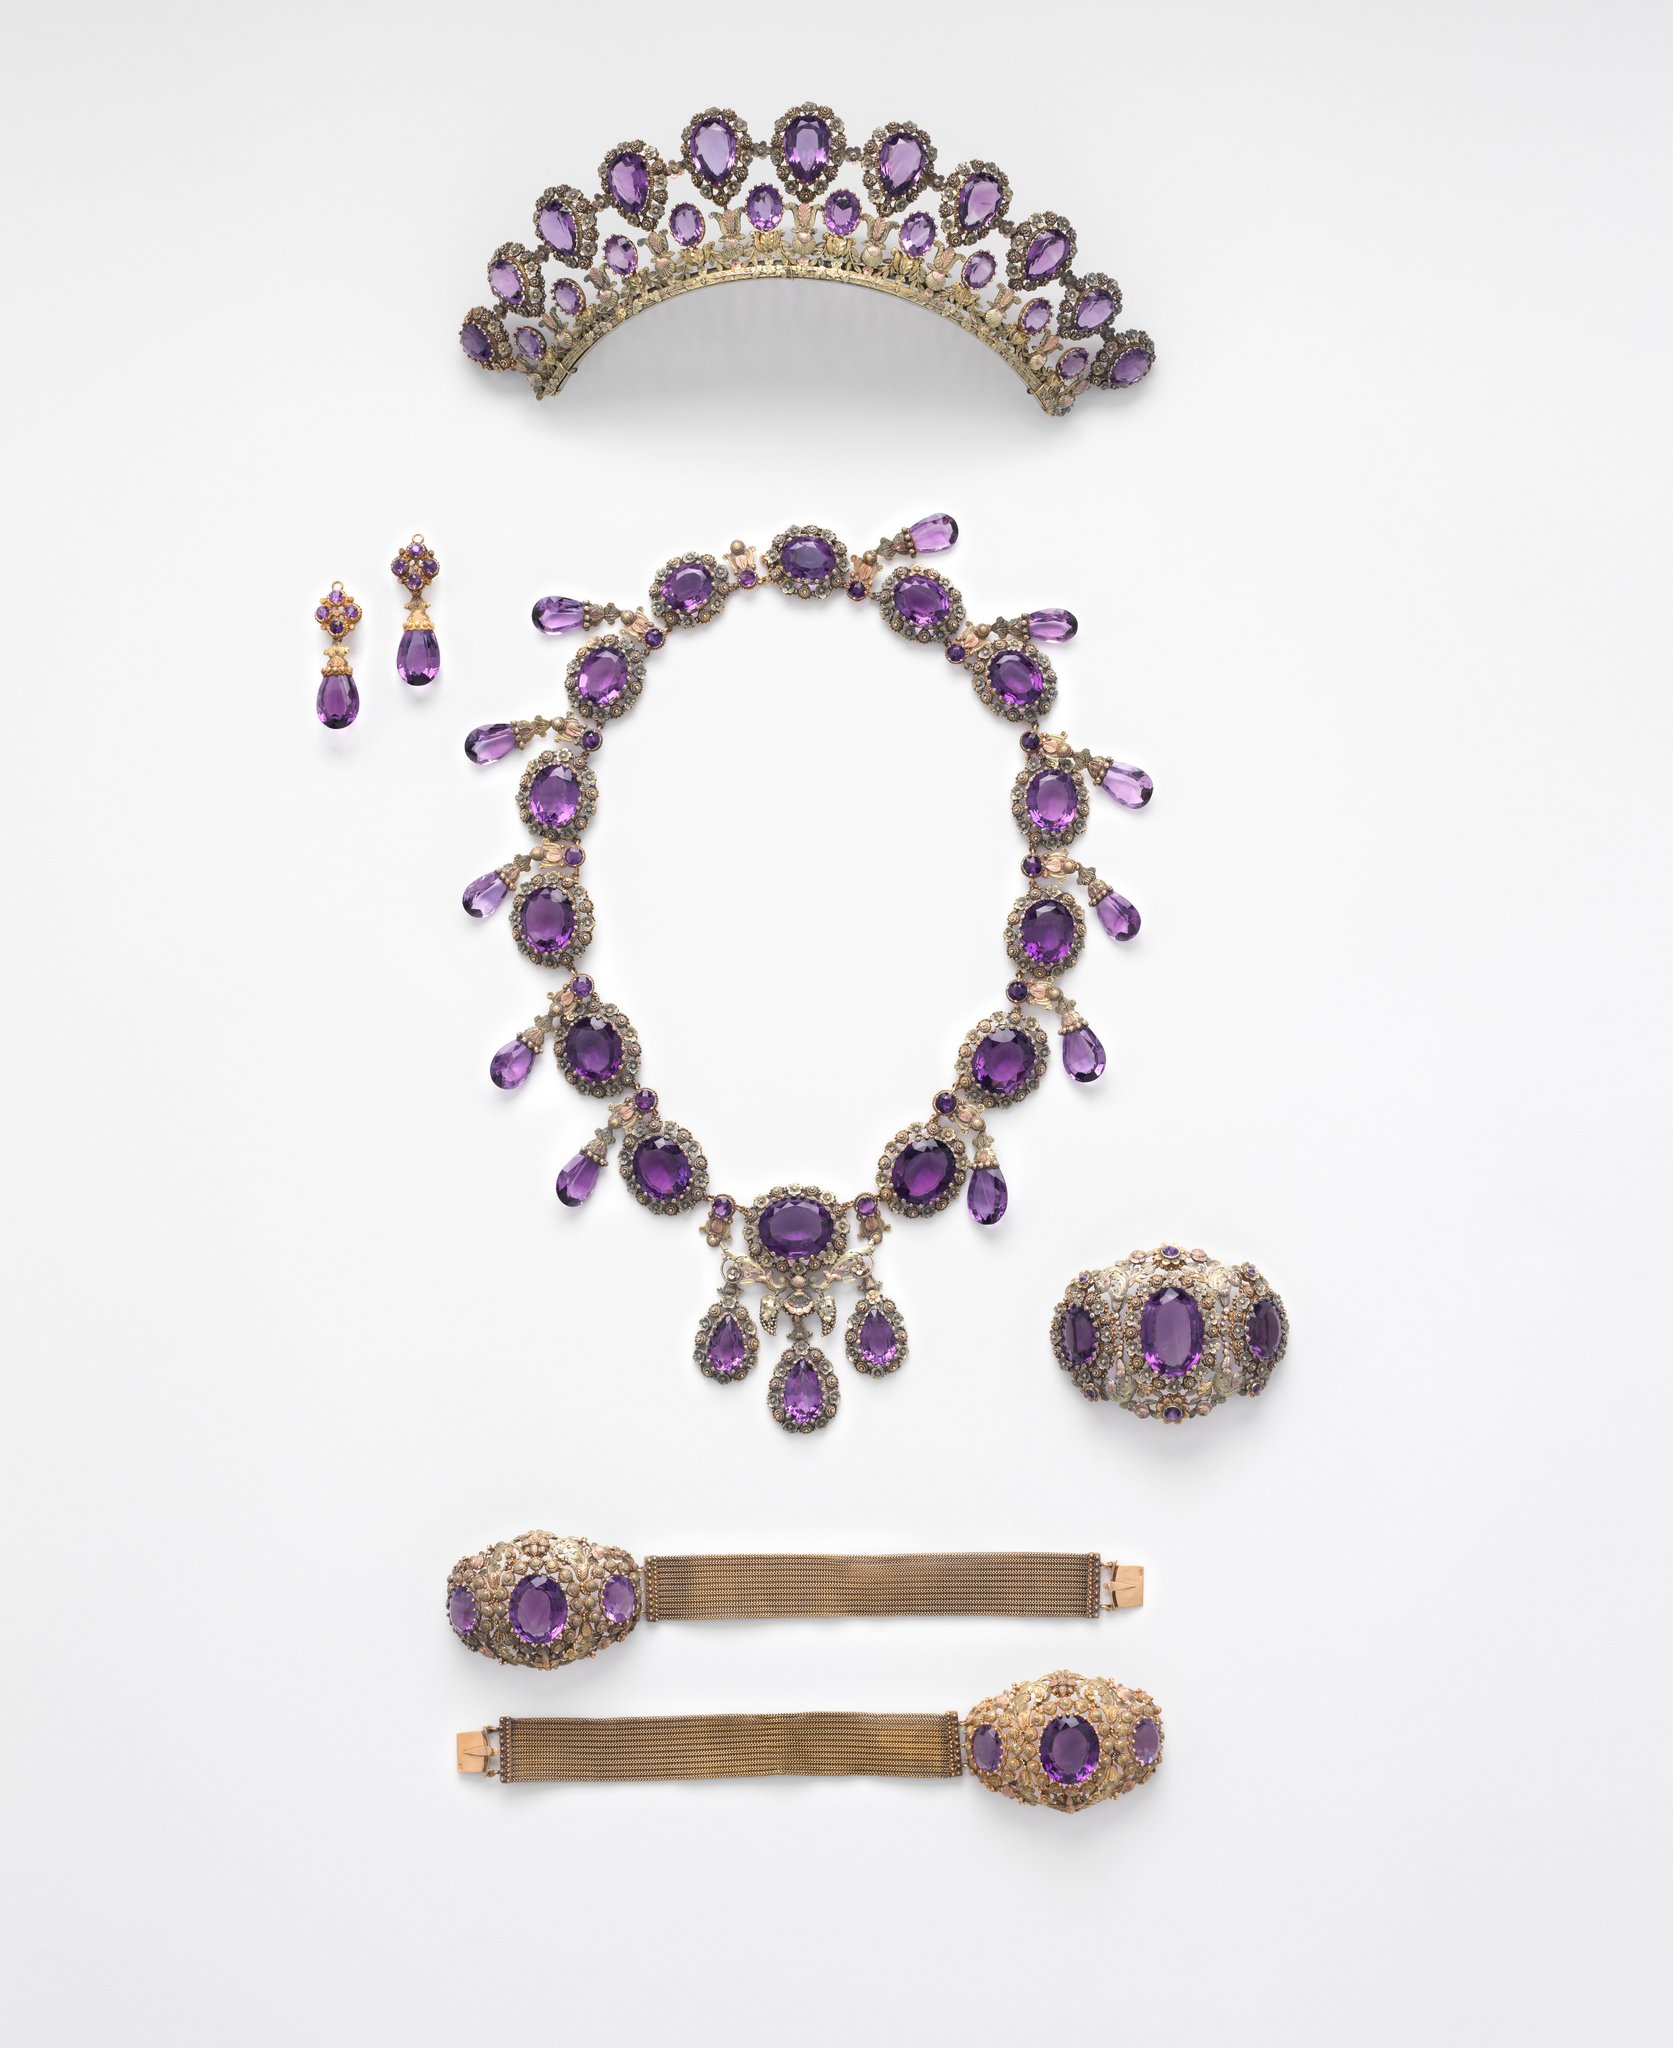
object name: brooch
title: Brooch (part of a set)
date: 1830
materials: amethyst, gold